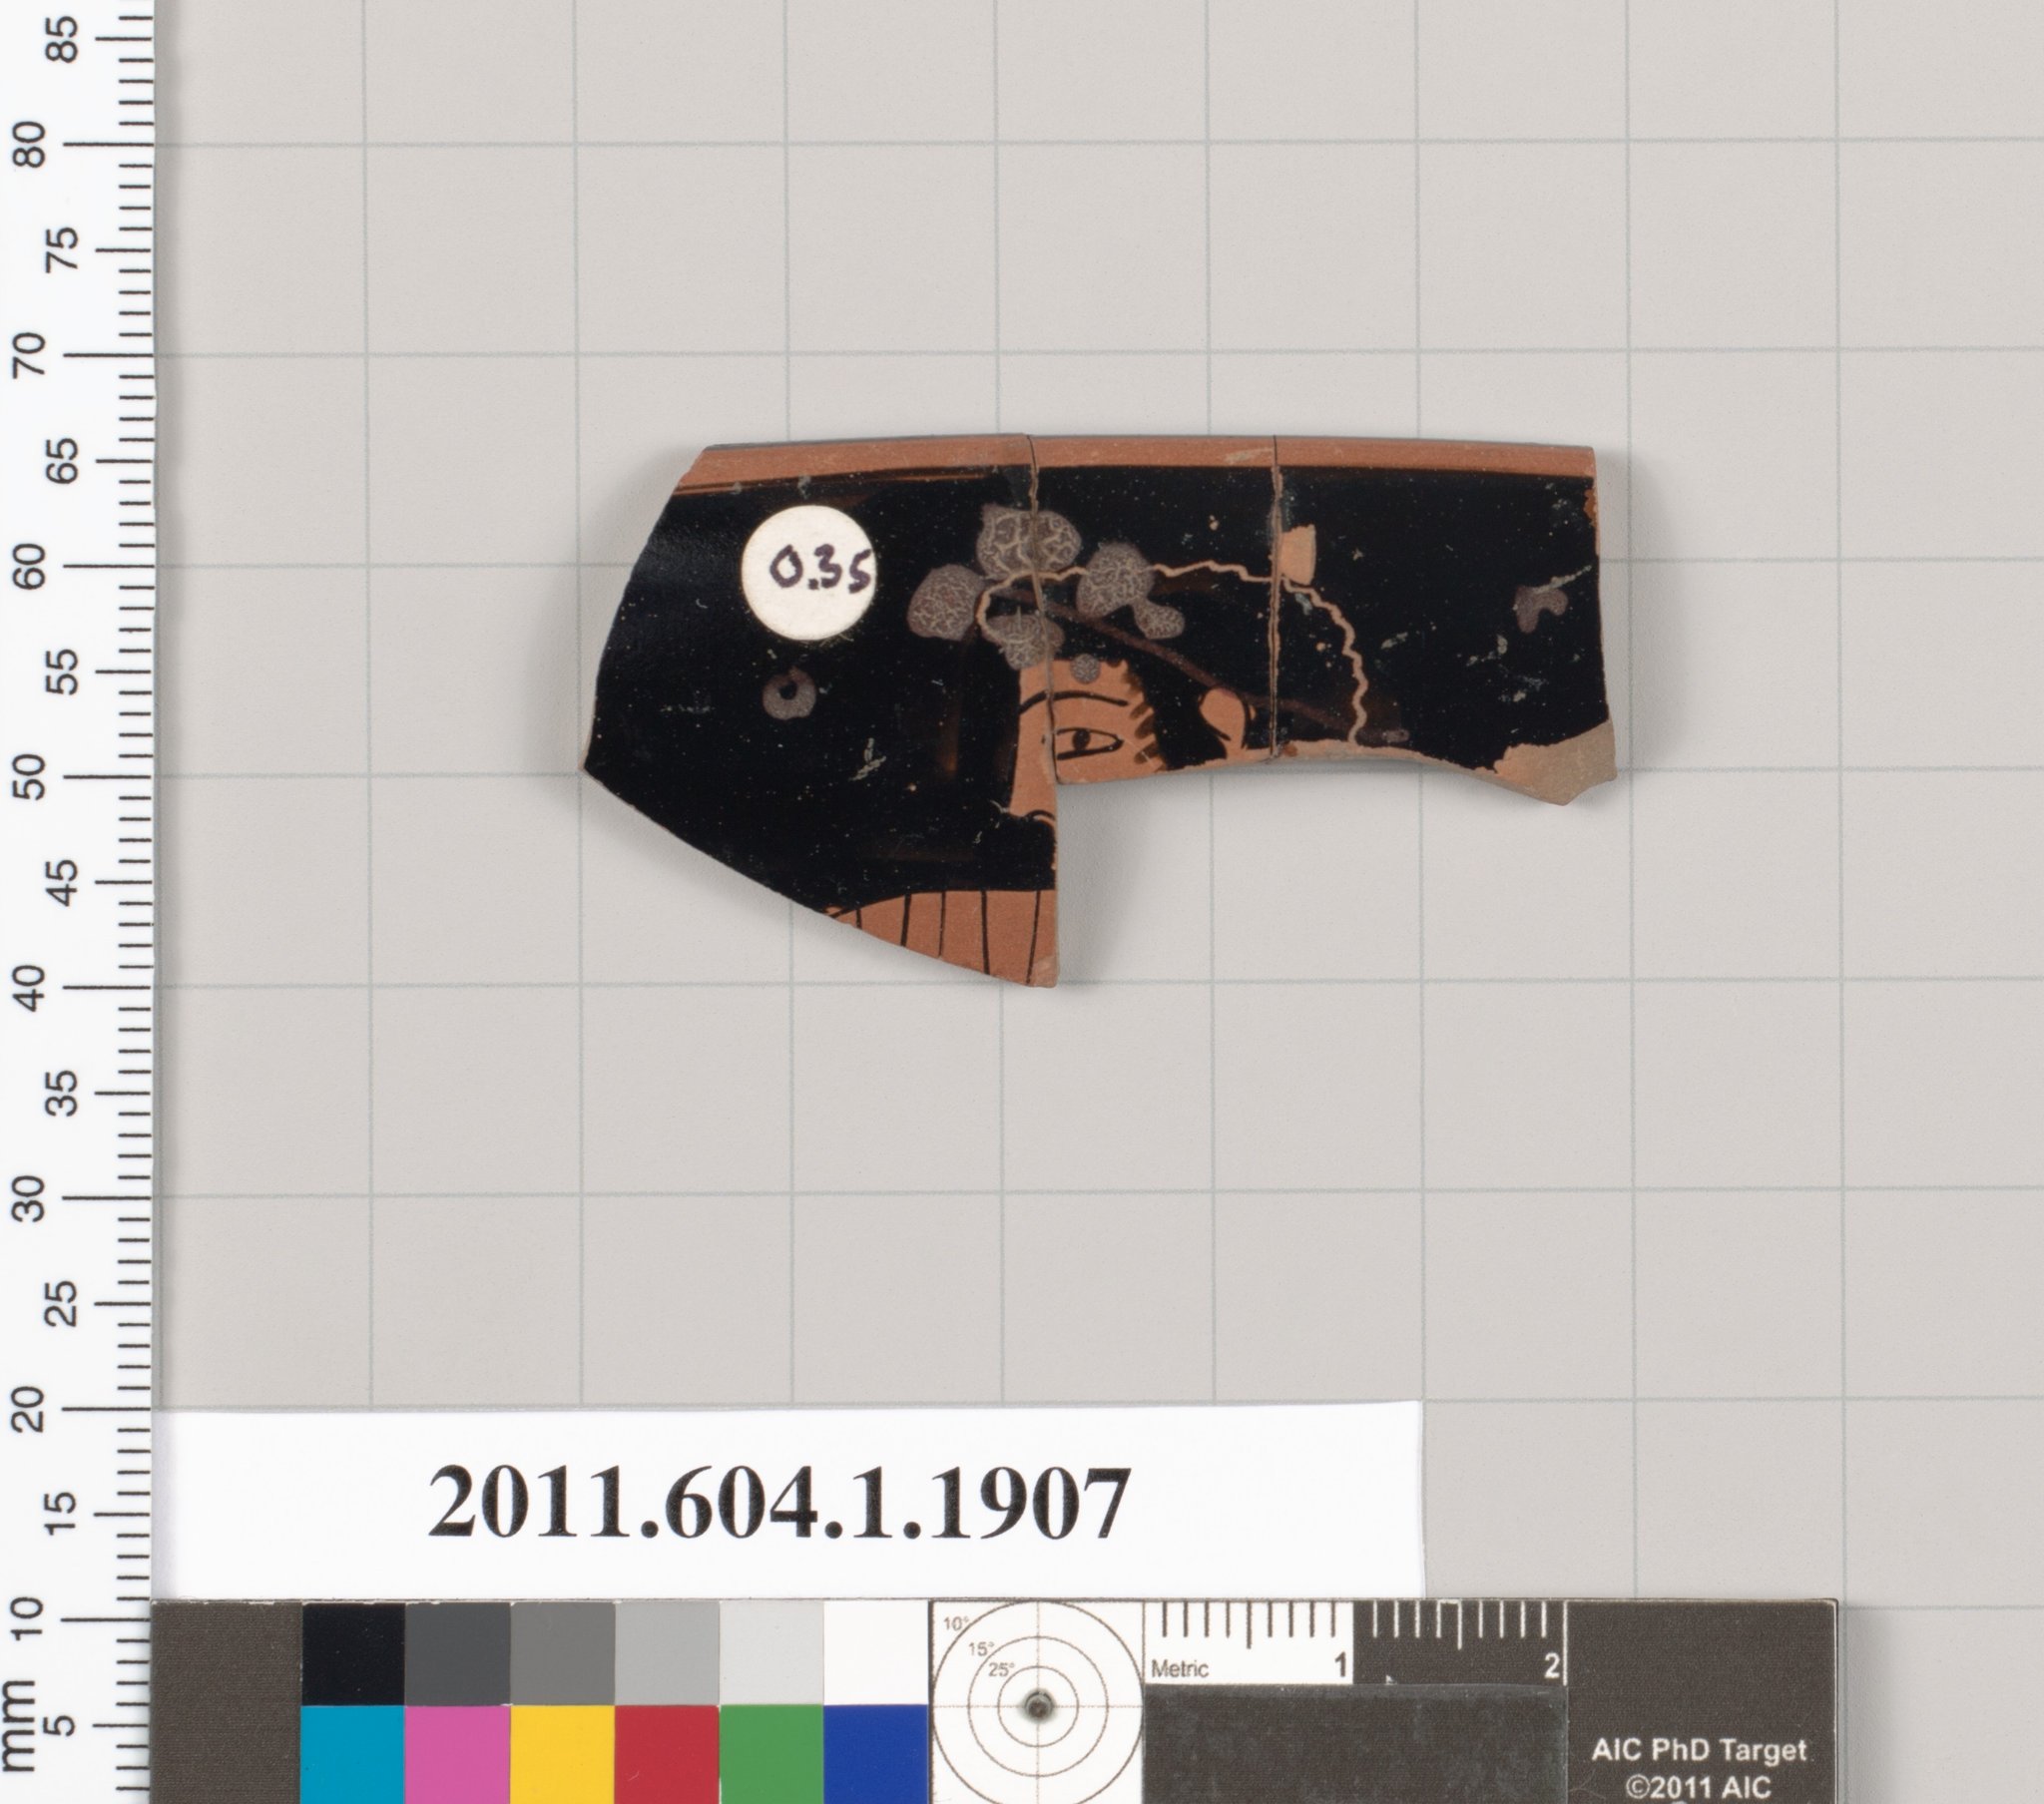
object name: kylix fragment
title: Terracotta rim fragment of a kylix (drinking cup)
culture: greek, attic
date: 534-468 BCE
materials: terracotta